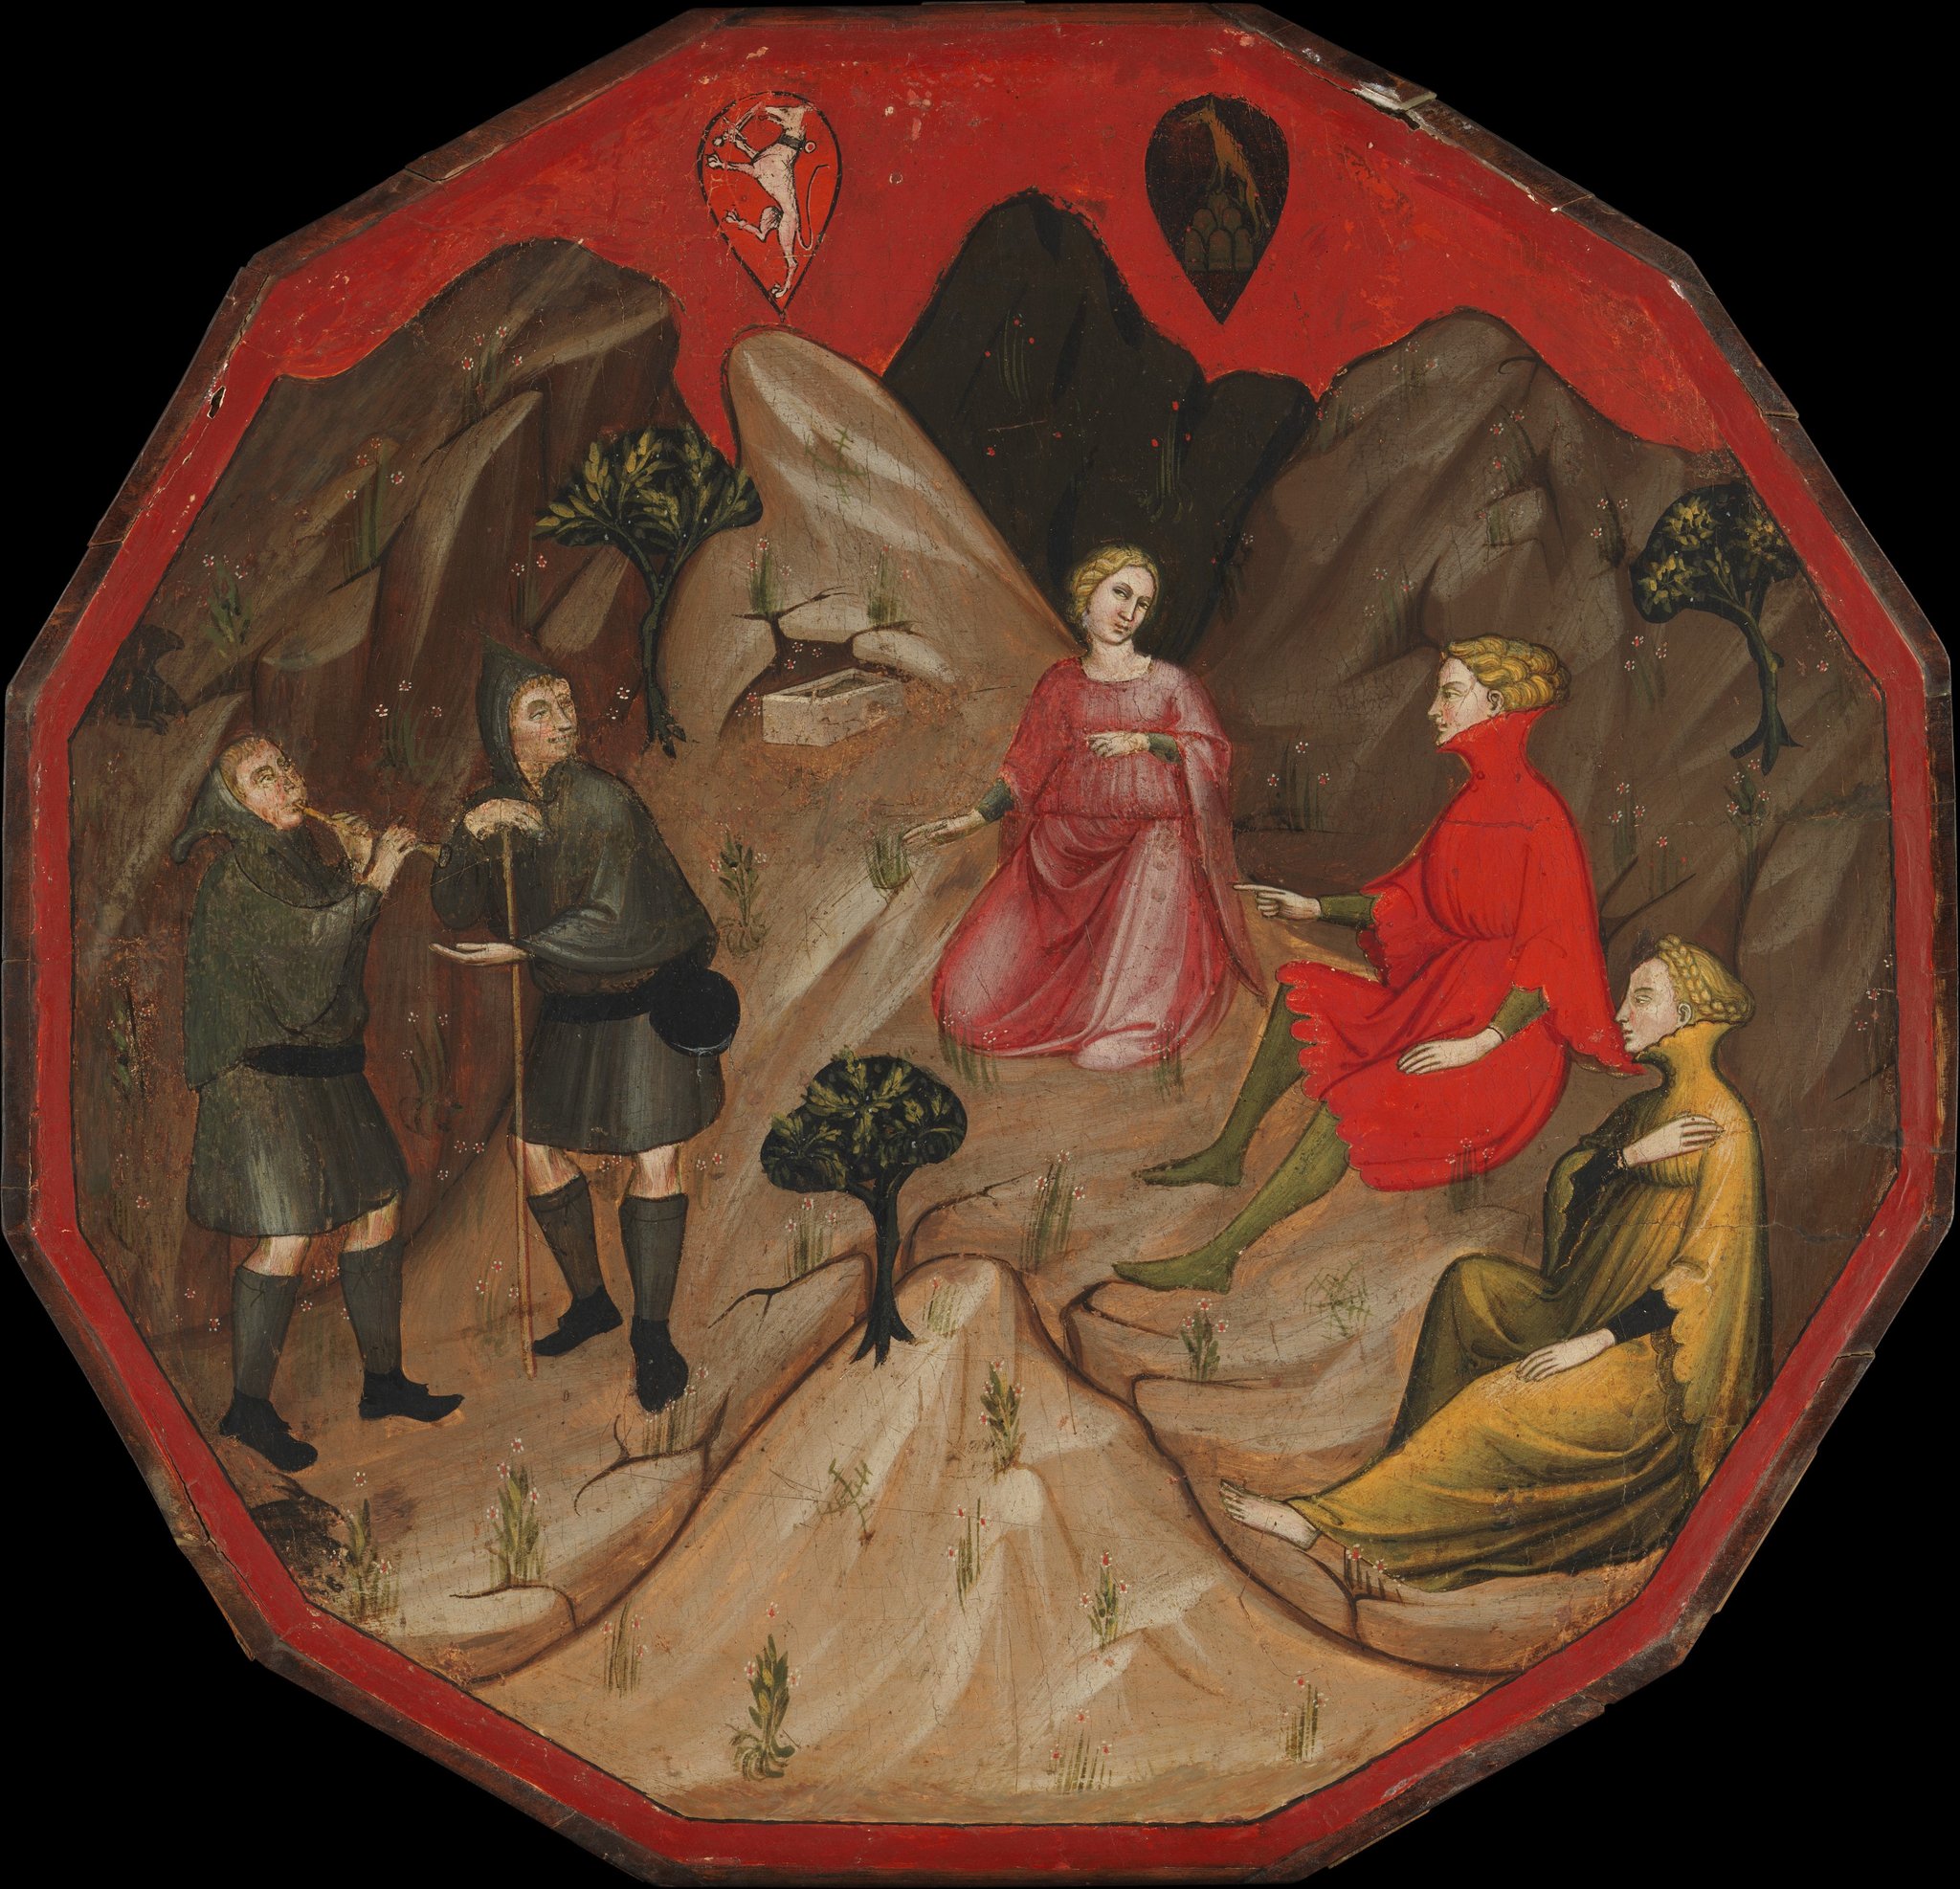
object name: painting, verso of a marriage salver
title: A Contest between the Shepherds Alcesto and Acaten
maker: master of 1416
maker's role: artist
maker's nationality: italian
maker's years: 1400-1429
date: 1410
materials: paint, wood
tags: men,women,shepherds